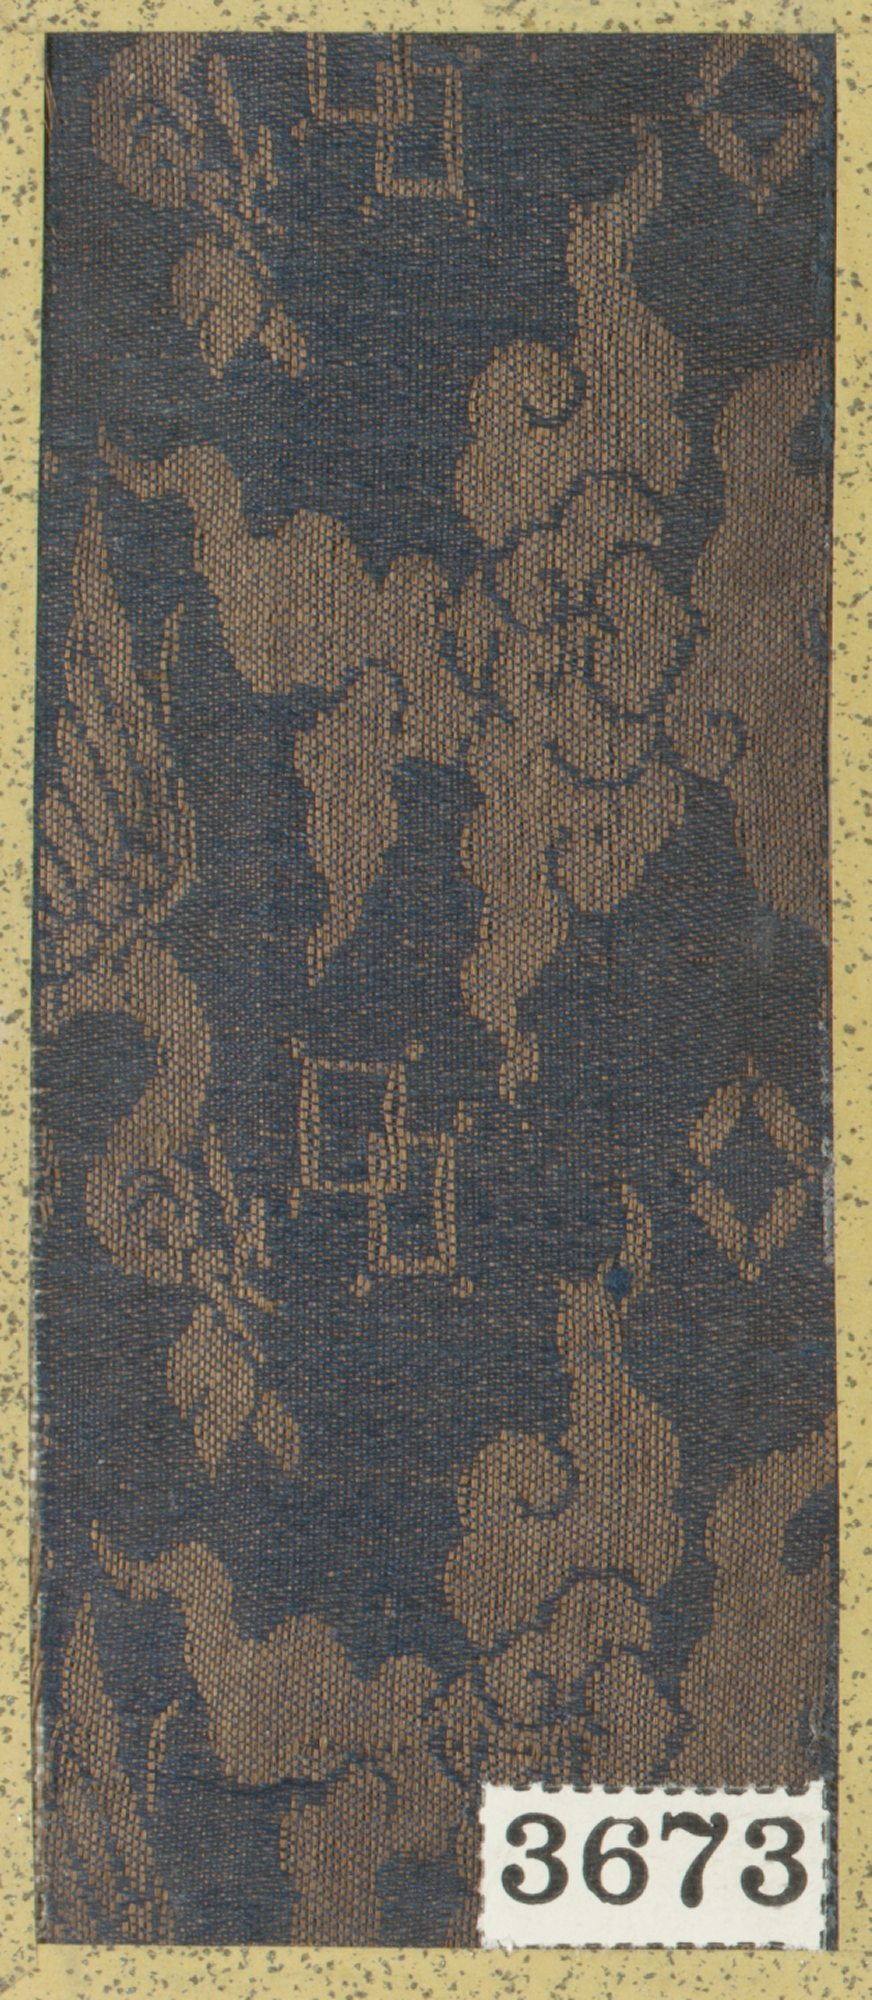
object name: sample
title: Textile Sample from Sample Book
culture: japanese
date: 1801-1900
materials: silk